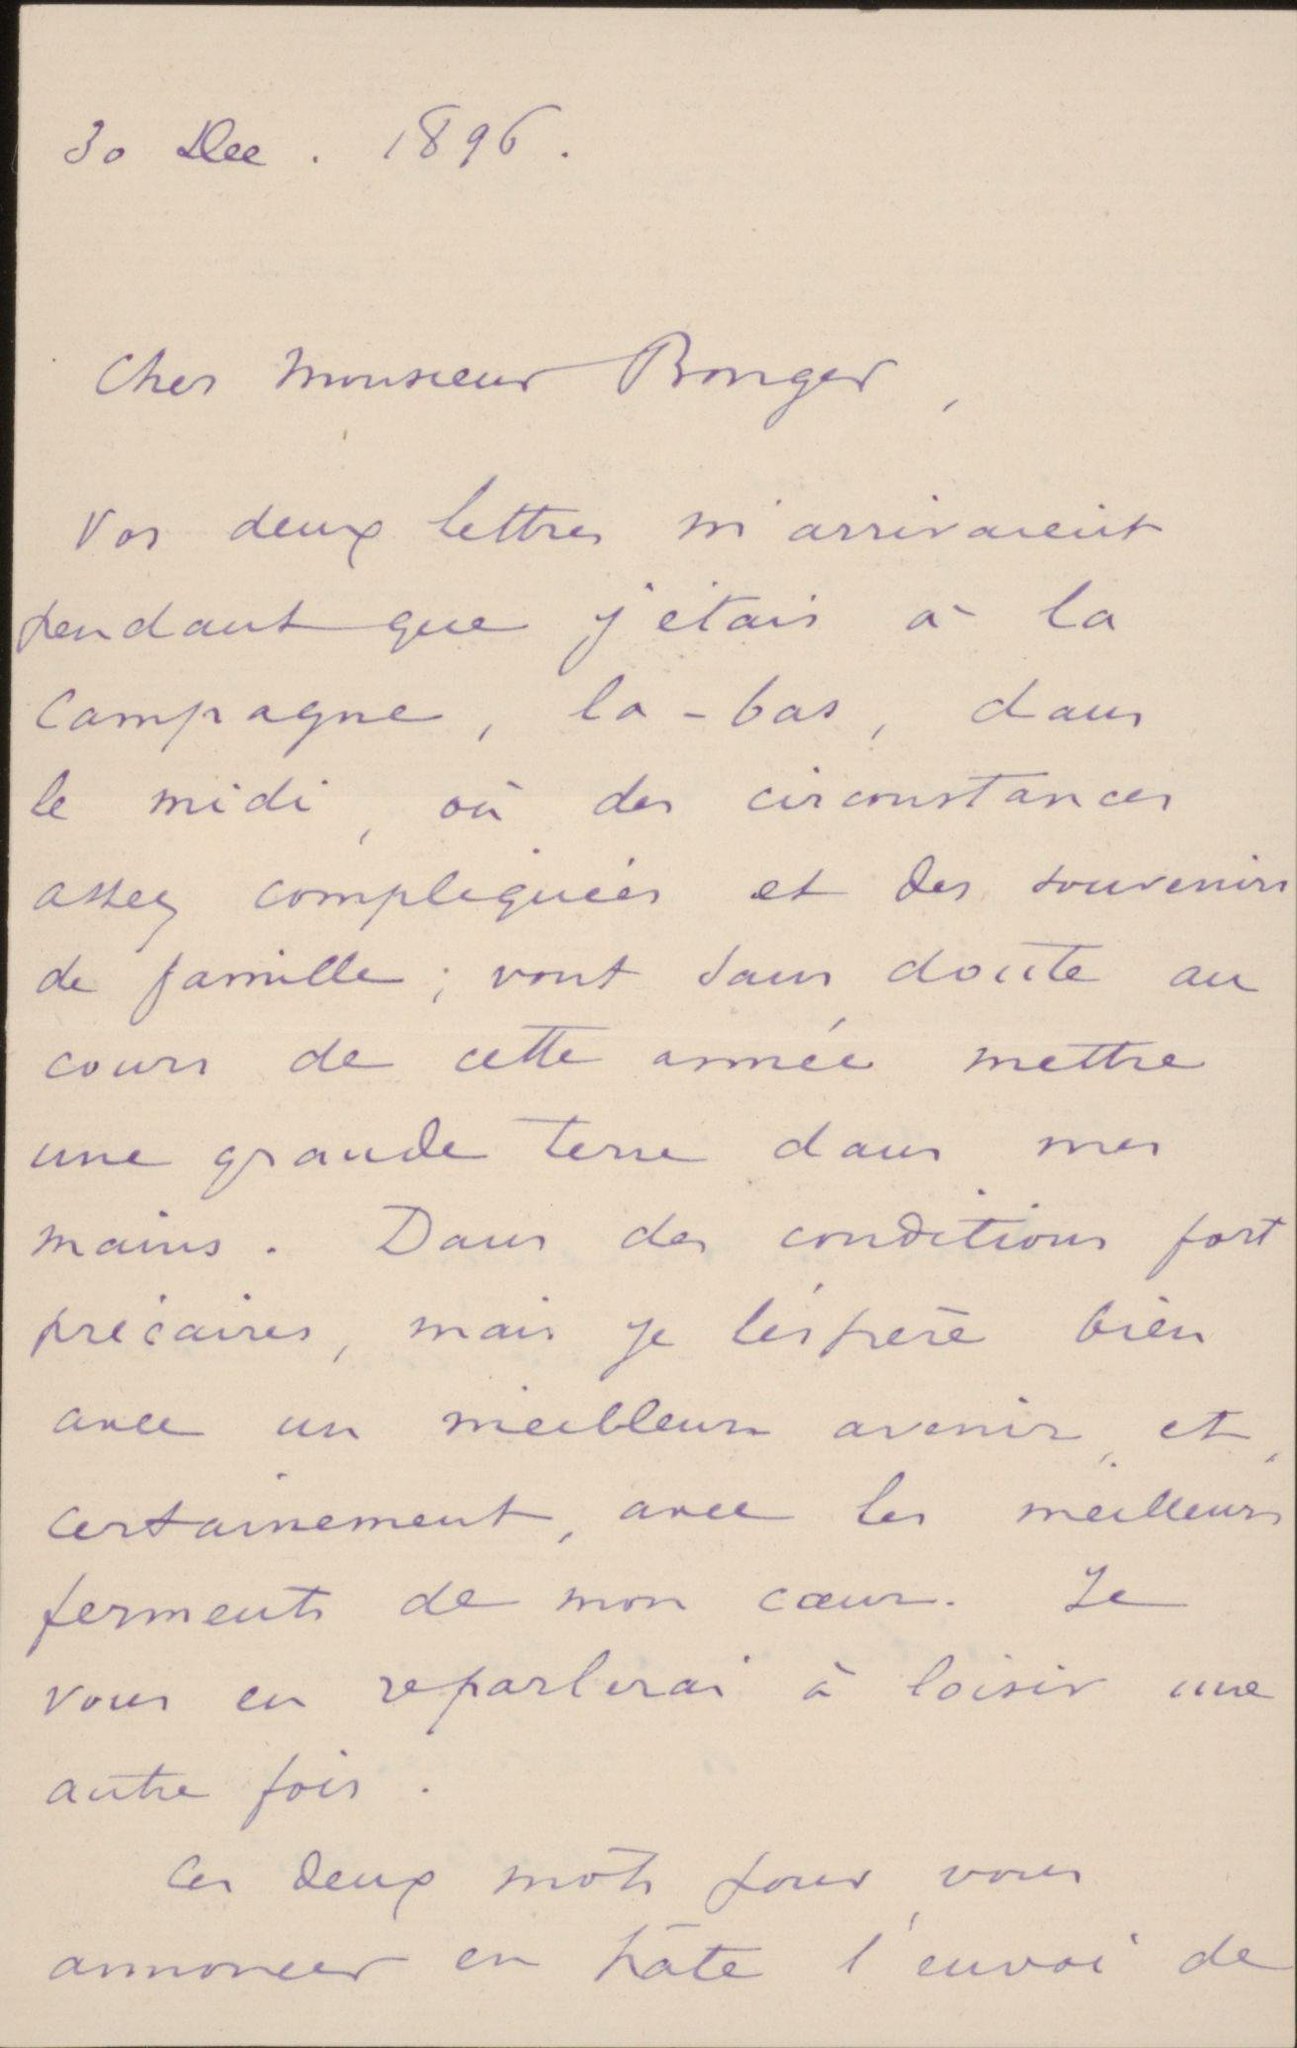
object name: letter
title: Brief aan Andries Bonger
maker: odilon redon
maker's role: draughtsman, painter, print maker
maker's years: 1840-1916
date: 1896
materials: ink, paper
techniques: pen, writing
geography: paris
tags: émile bernard, andries bonger, the graphic arts, printed matter, sevilla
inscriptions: watermark